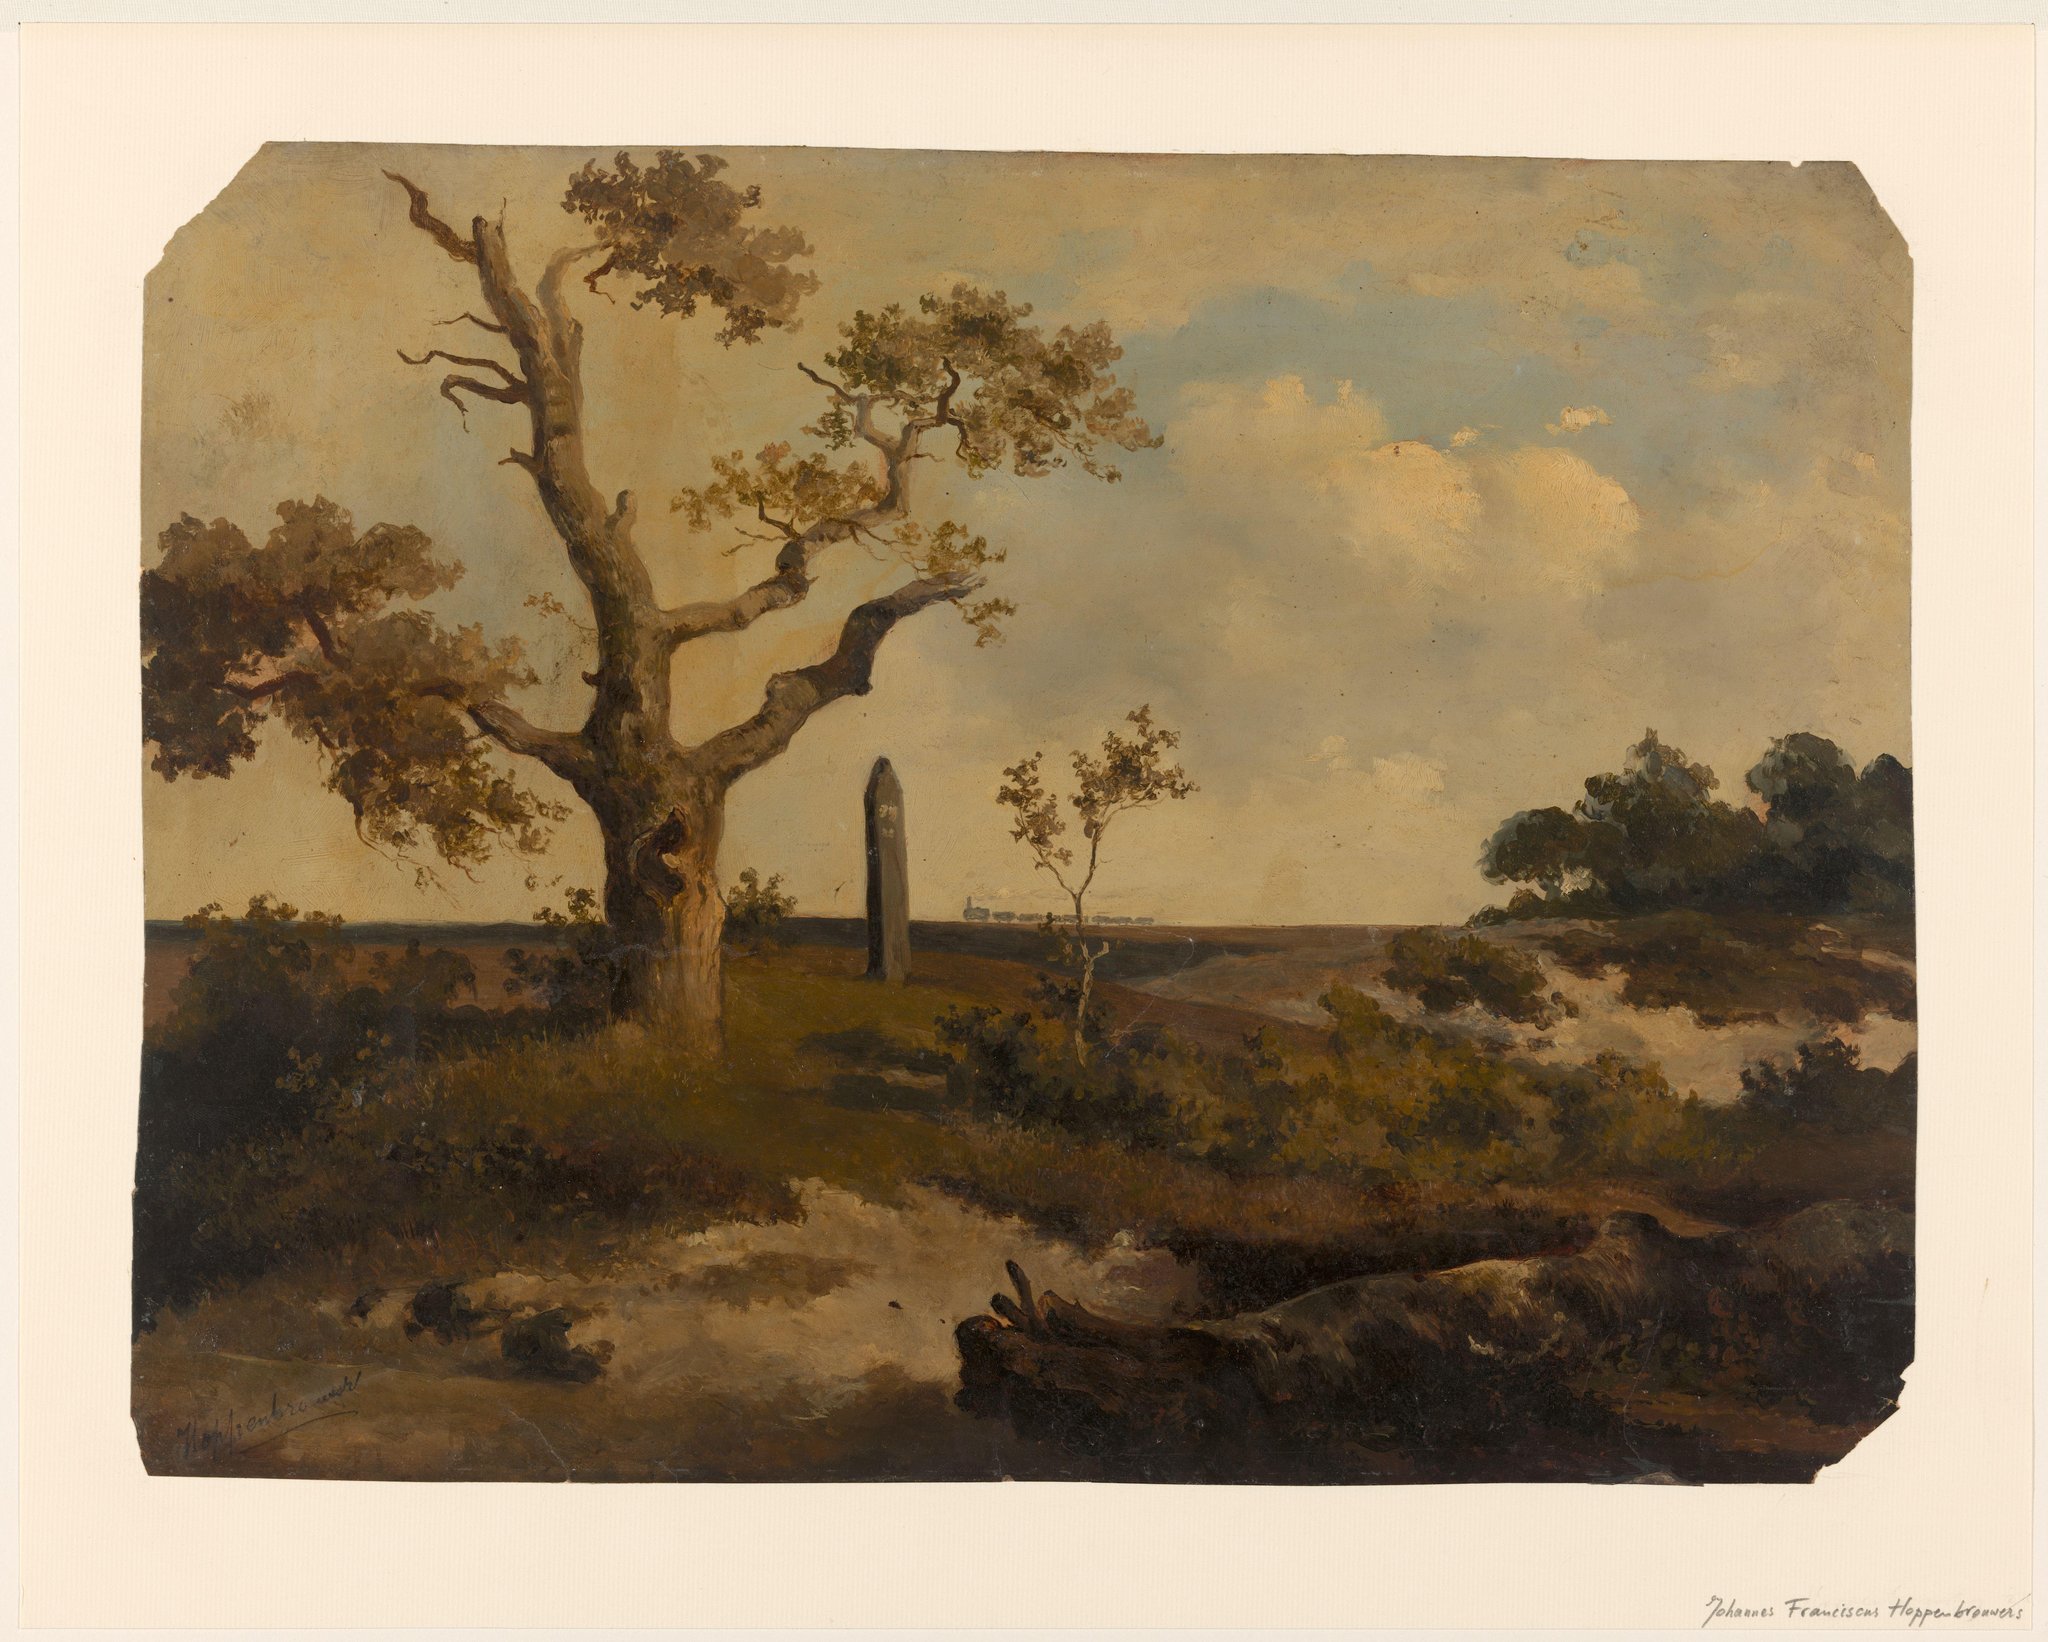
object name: drawing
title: Landschap met trein in het verschiet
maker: johannes franciscus hoppenbrouwers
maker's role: draughtsman, painter, print maker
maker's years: 1819-1866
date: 1829-1866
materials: oil, paper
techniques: brush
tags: railway, tramway; rack railway (+ propulsion of vehicle, ship, etc. by steam), landscapes in the temperate zone, milestone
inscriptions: collector's mark: Lugt 2228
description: Rechts van de knoestige boom staat mogelijk een milliarium. In de verte rijdt een stoomtrein langs de horizon.